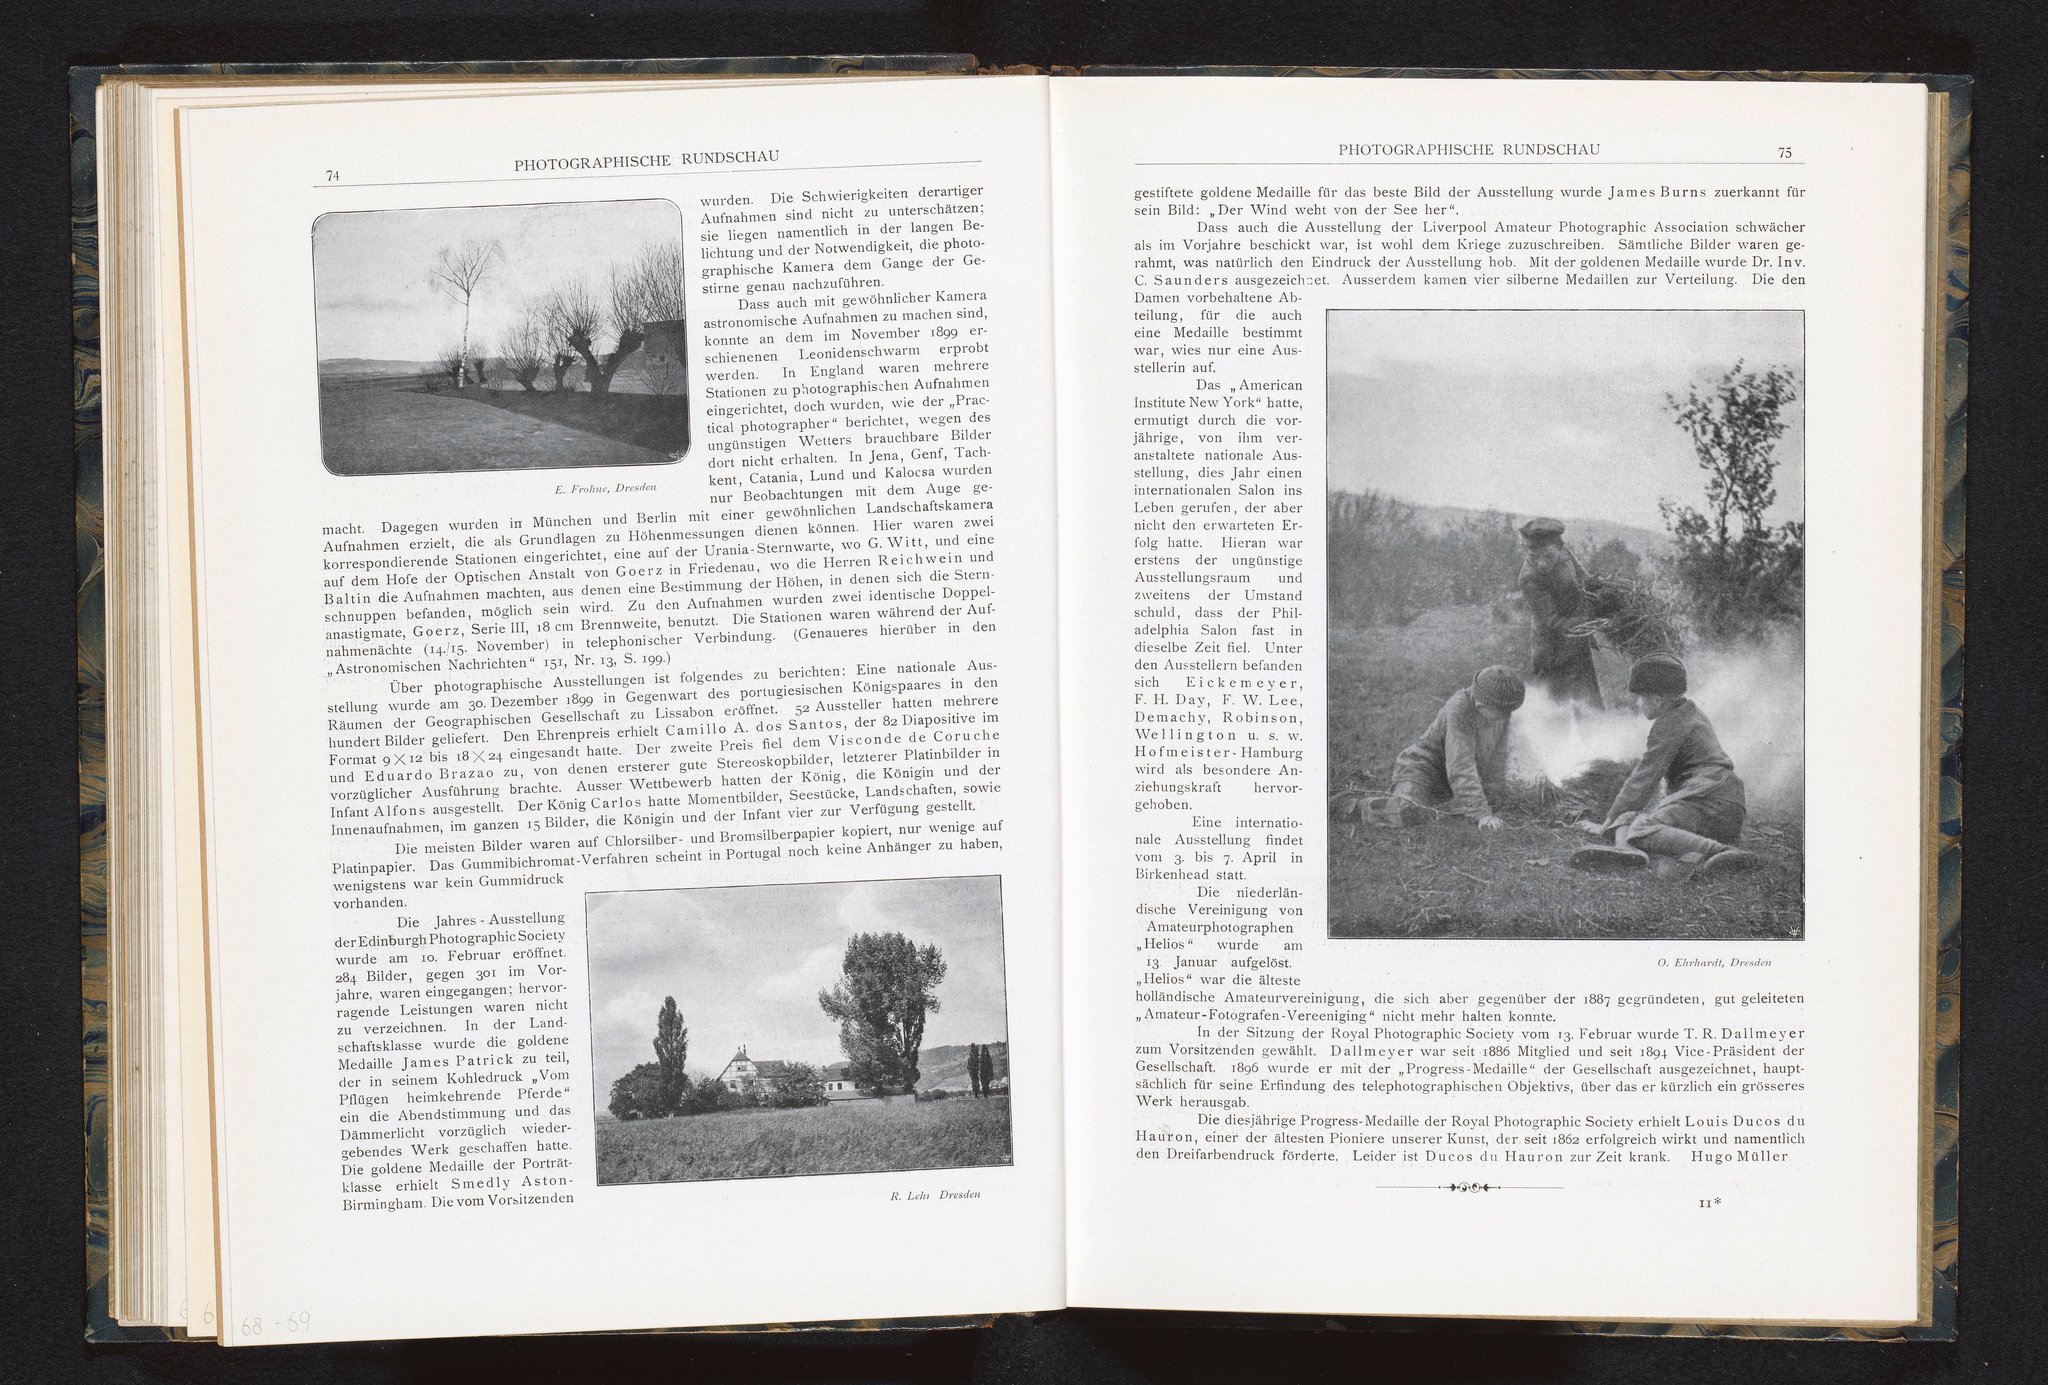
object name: photomechanical print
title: Gezicht op drie jongens die een kampvuur maken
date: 1895-1900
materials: paper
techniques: autotype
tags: child, camp-fire; watch-fire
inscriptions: monogram: ‘WC’